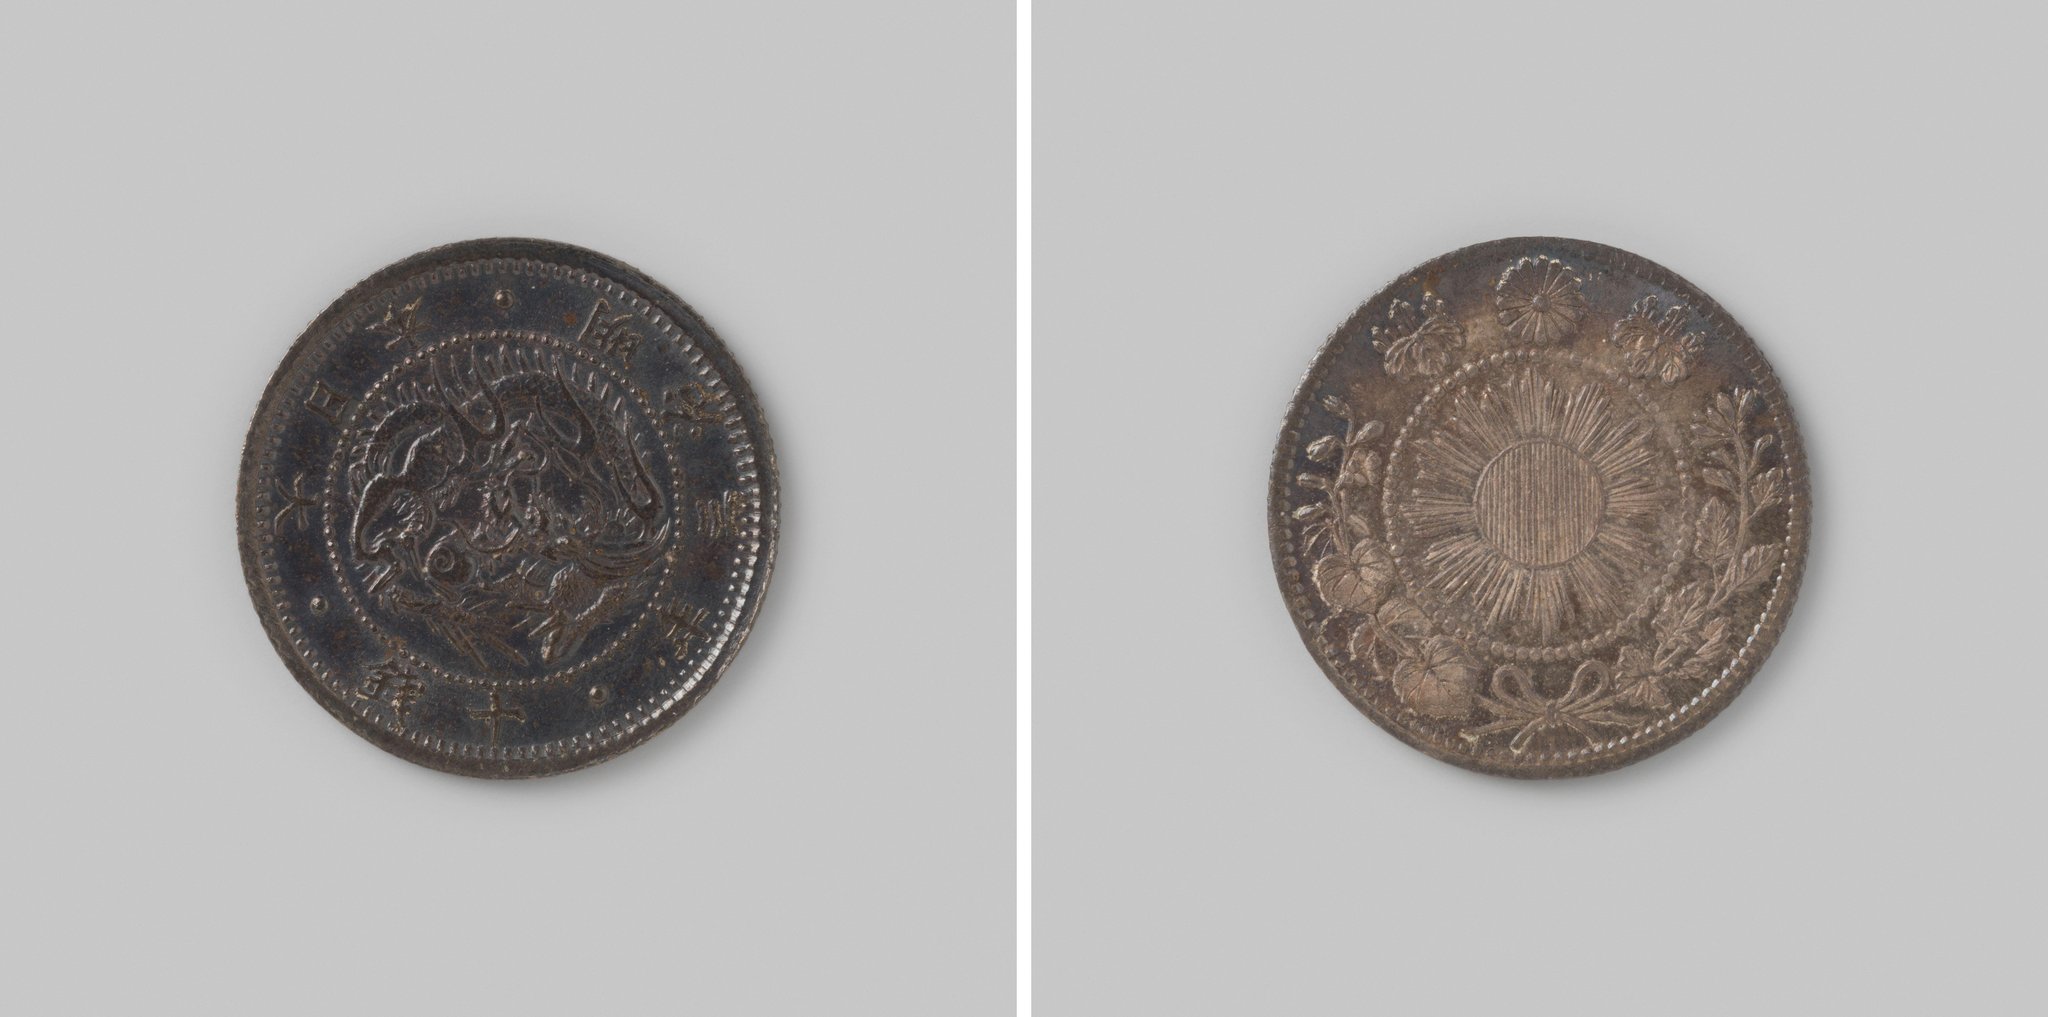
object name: tien sen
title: 10 sen van het keizerrijk Japan, uit het Meiji tijdperk, regeringsjaar 3 [=1870]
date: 1870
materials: silver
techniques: striking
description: Zilveren munt. Voorzijde: binnen cirkel gestileerde draak met in omschrift onderaan waarde-aanduiding. Keerzijde: tussen twee samengebonden takken, waarboven symbolen, binnen cirkel zon met stralen. Kartelrand.